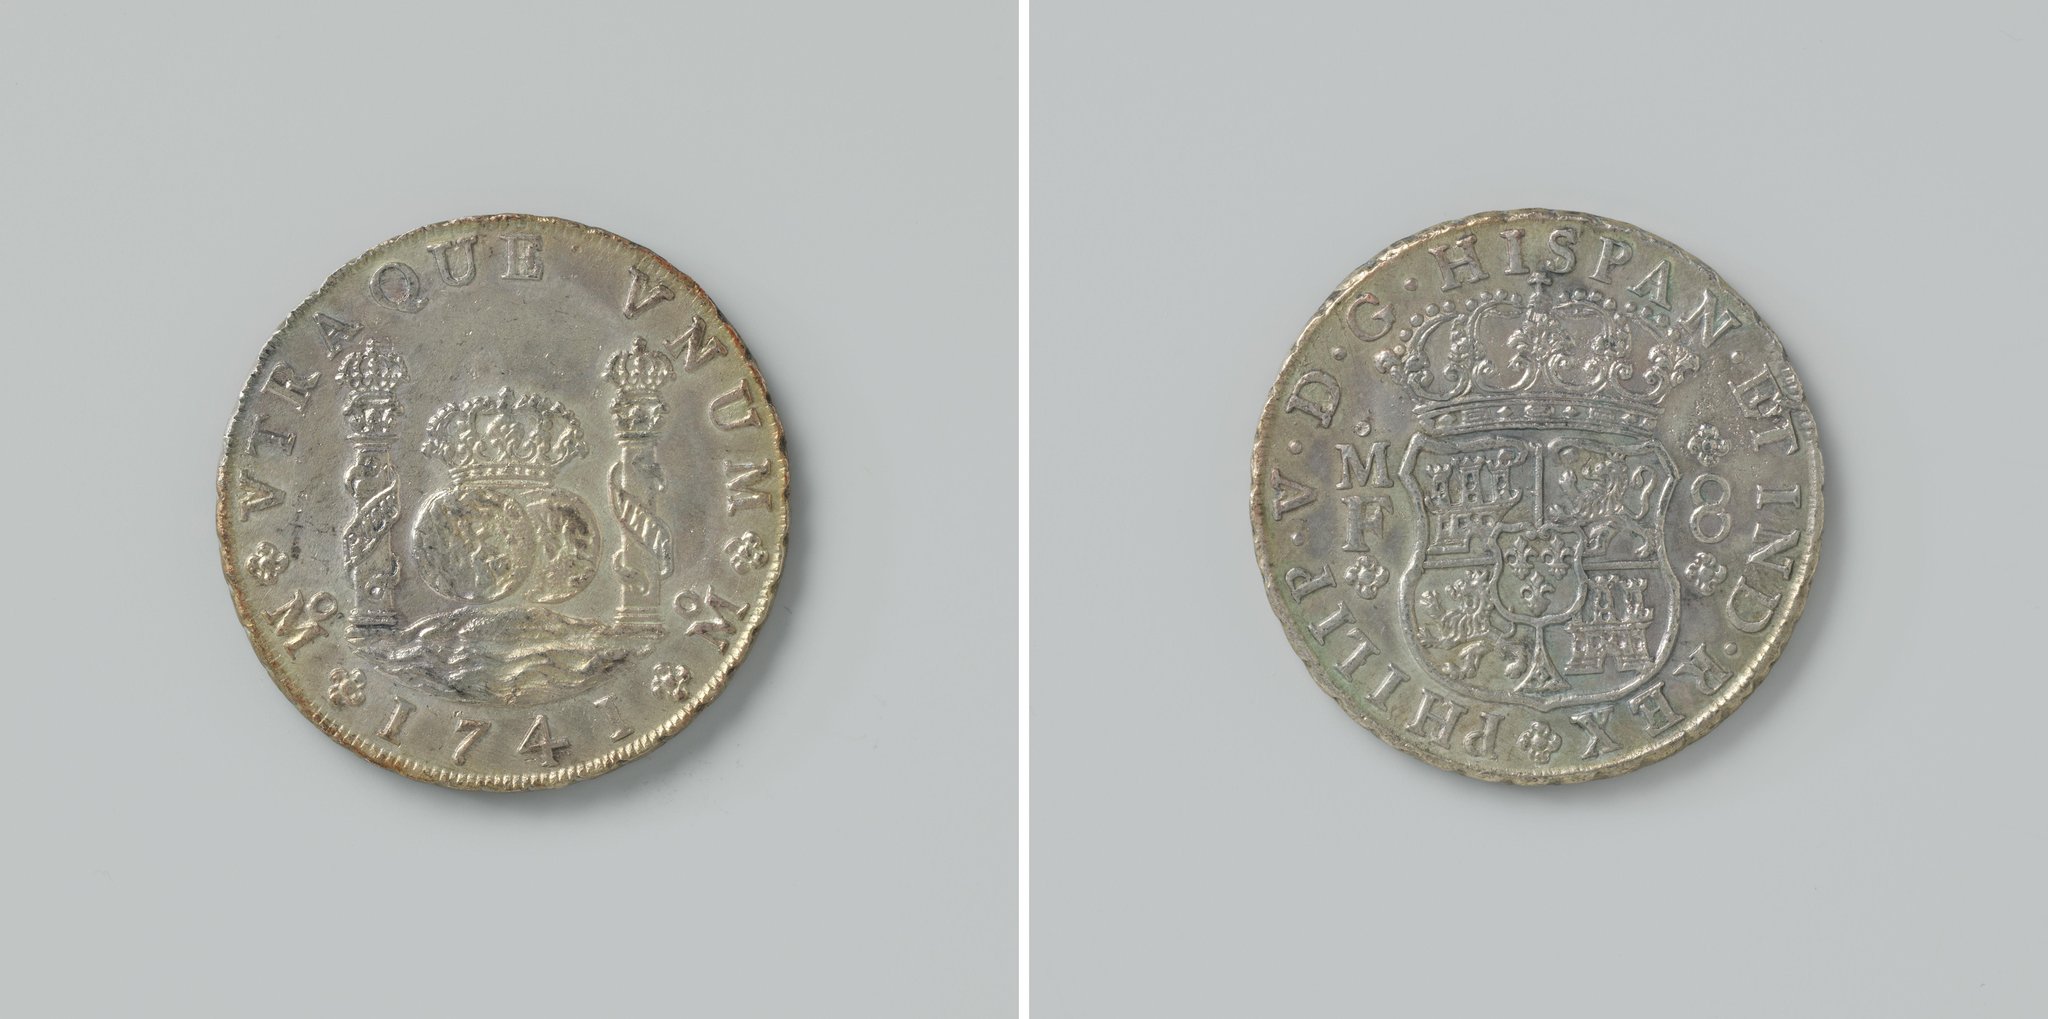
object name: coin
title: acht reaal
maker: Anonymous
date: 1741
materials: silver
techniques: striking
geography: mexico city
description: Spaans-Amerika, acht reaal uit VOC-wrak Hollandia 1742.